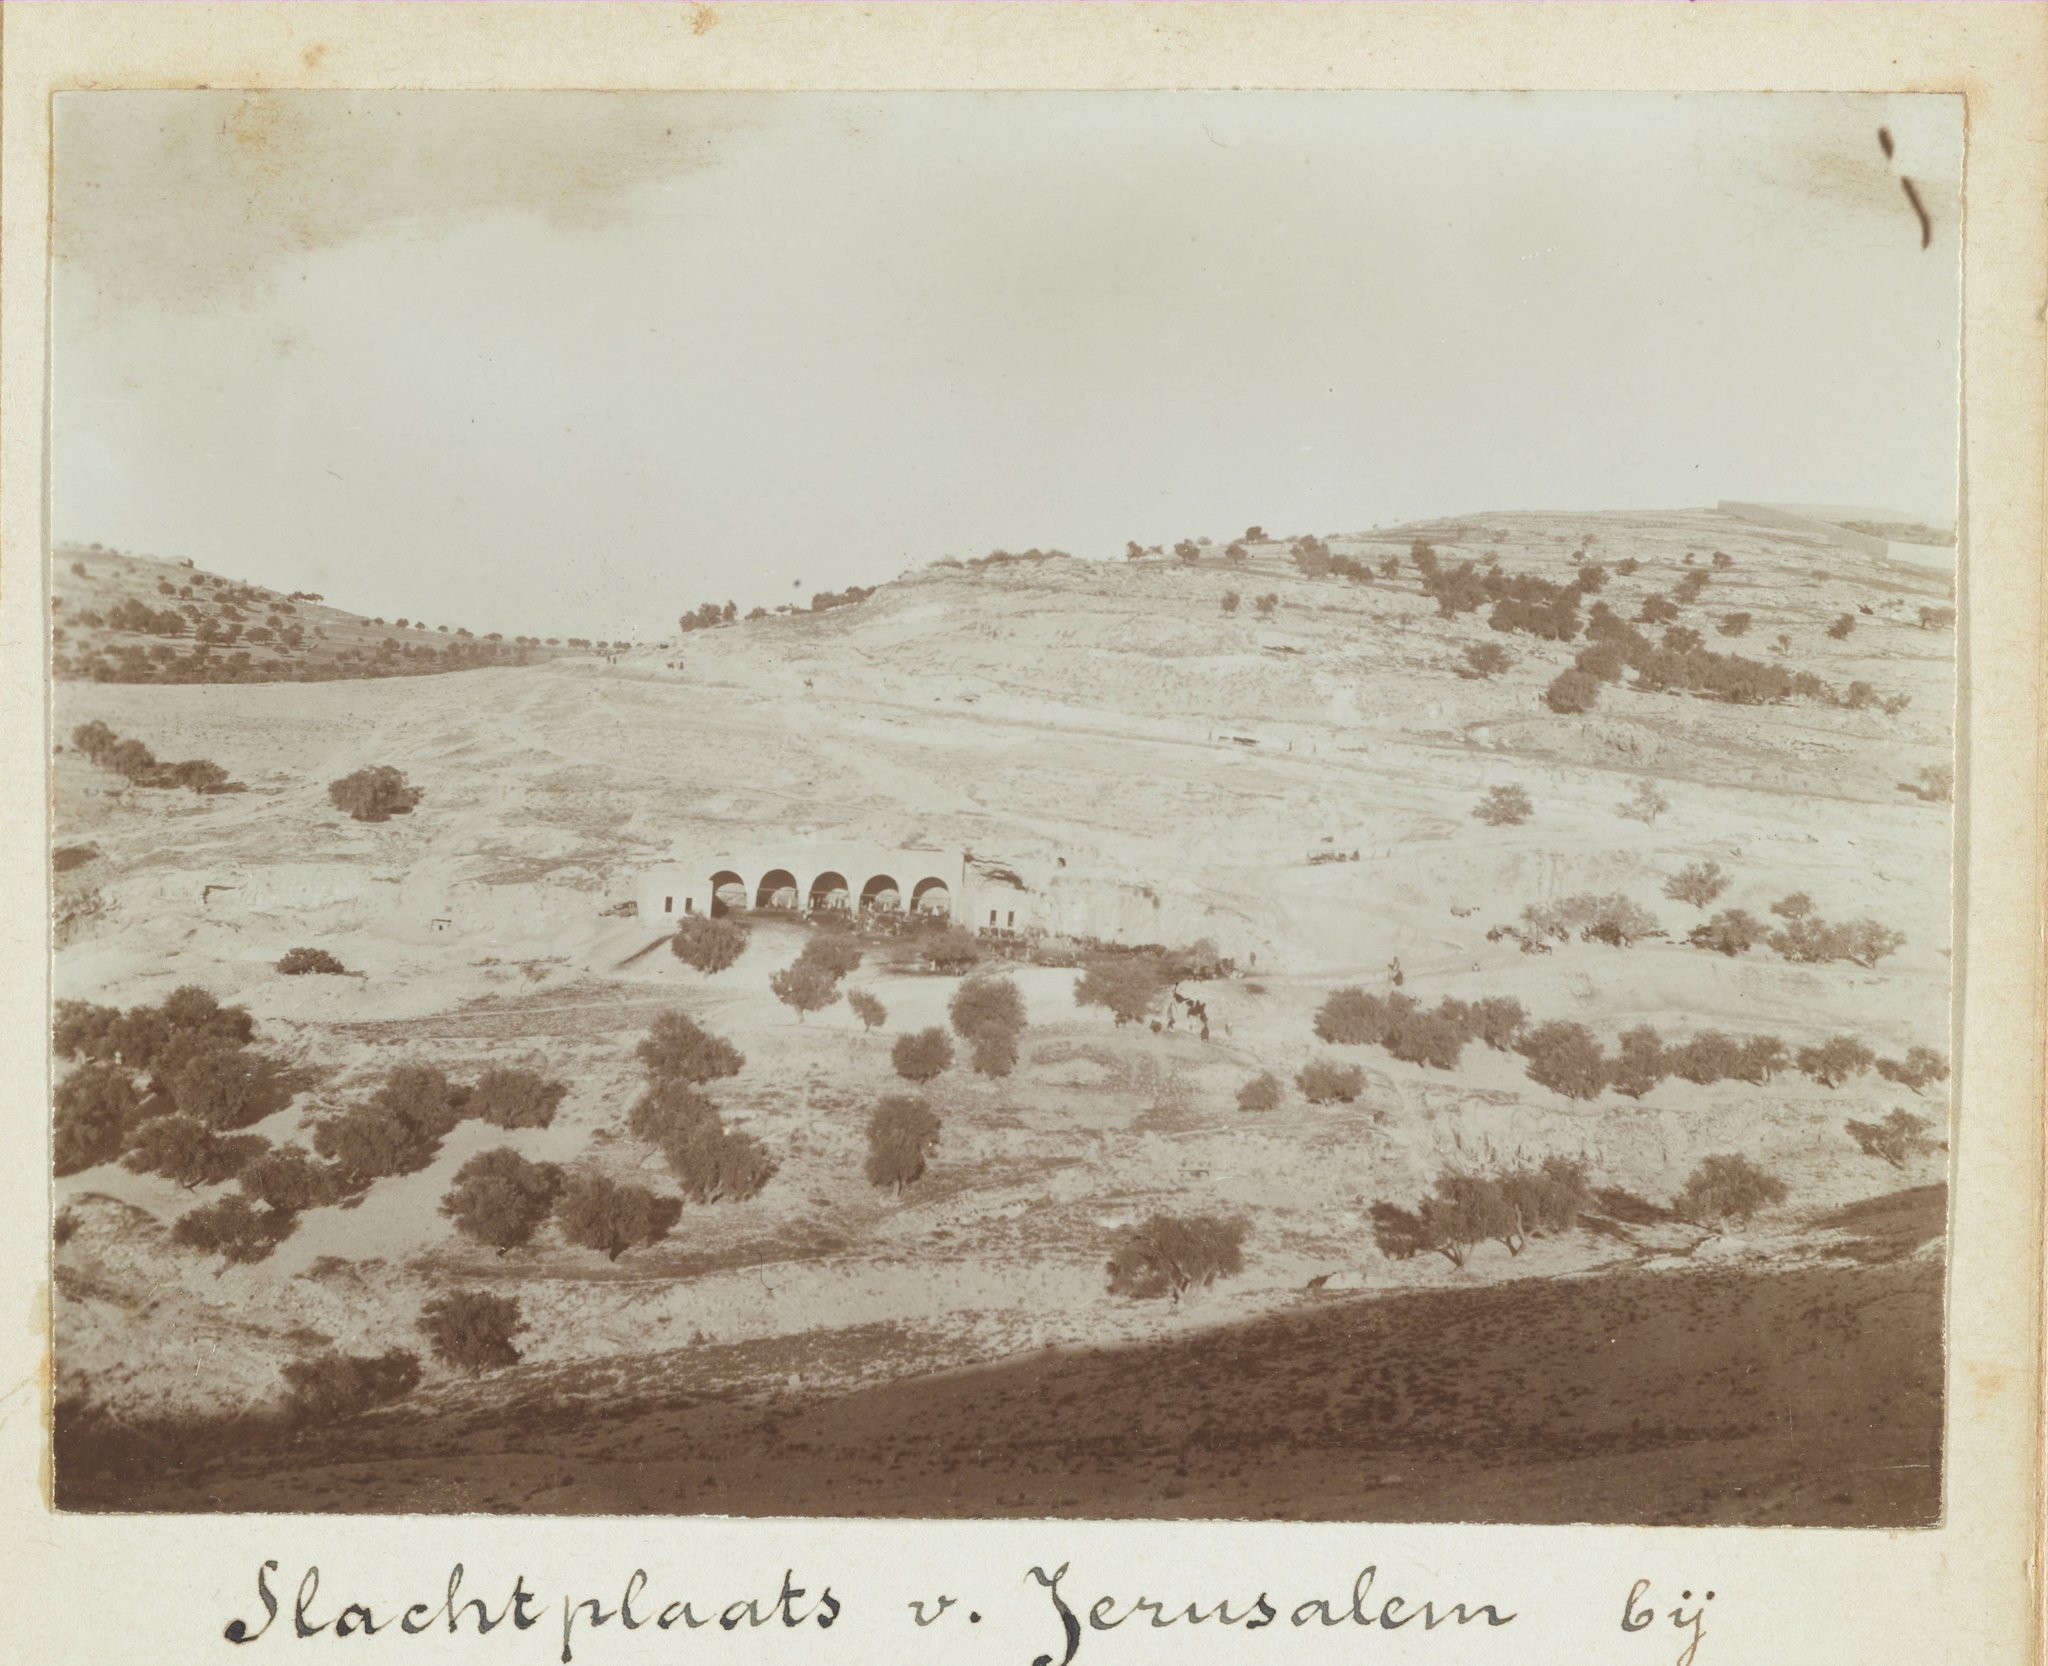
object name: page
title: Gezicht op een slachtplaats bij Bethanië, het tegenwoordige Al-Eizariya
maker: johannes lodewijk heldring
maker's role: fotograaf, predikant, schrijver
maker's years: 1852-1923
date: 1898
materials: paper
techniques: collodion silver print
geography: west bank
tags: butcher, slaughterman